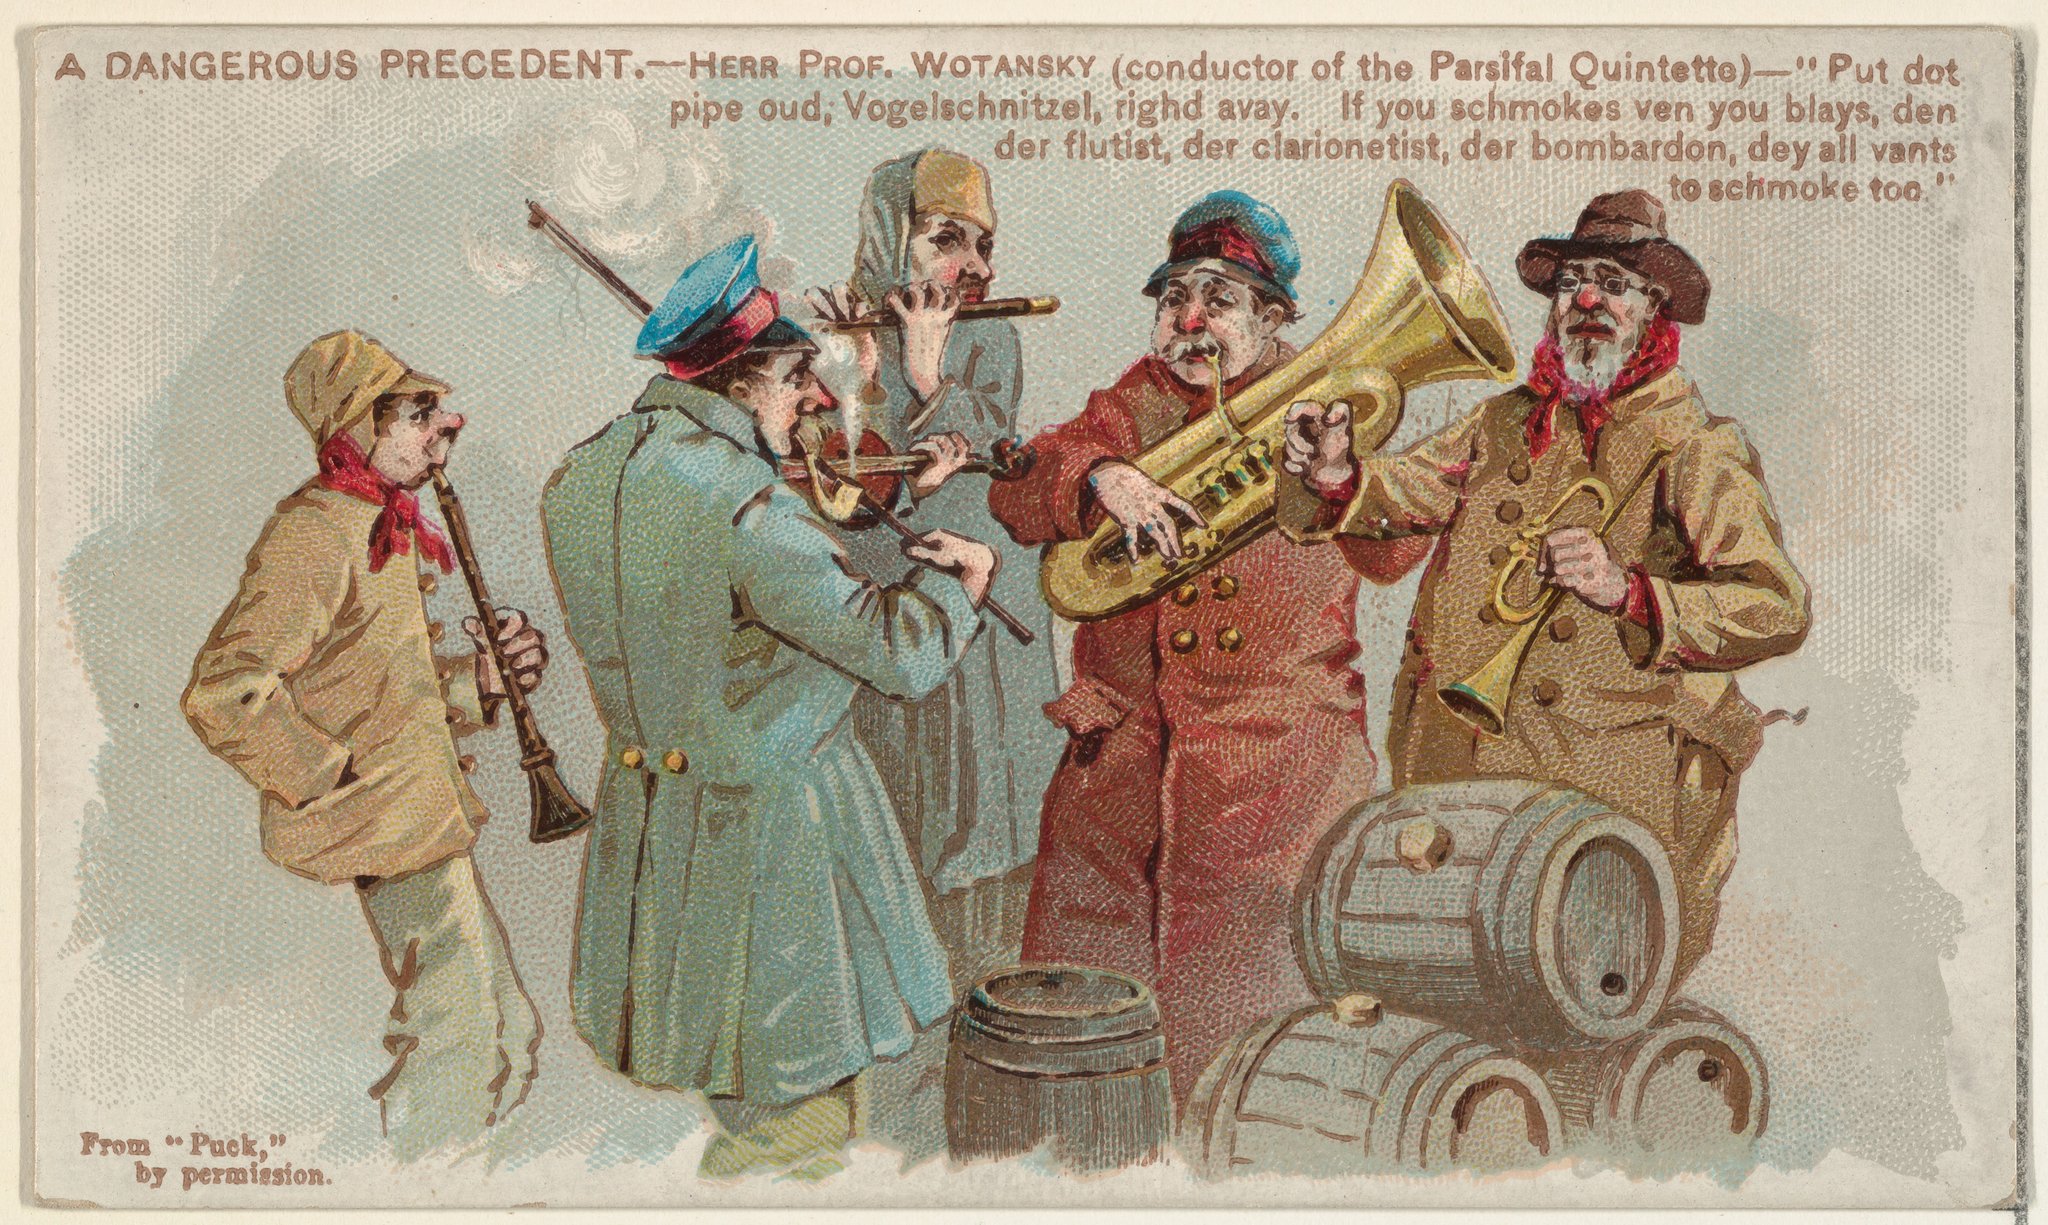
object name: print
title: A Dangerous Precedent, from the Snapshots from "Puck" series (N128) issued by Duke Sons & Co. to promote Honest Long Cut Tobacco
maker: w. duke, sons & co.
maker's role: publisher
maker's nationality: american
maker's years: 1870-1920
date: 1888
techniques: color lithograph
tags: men,flutes,horns,trumpets,musicians